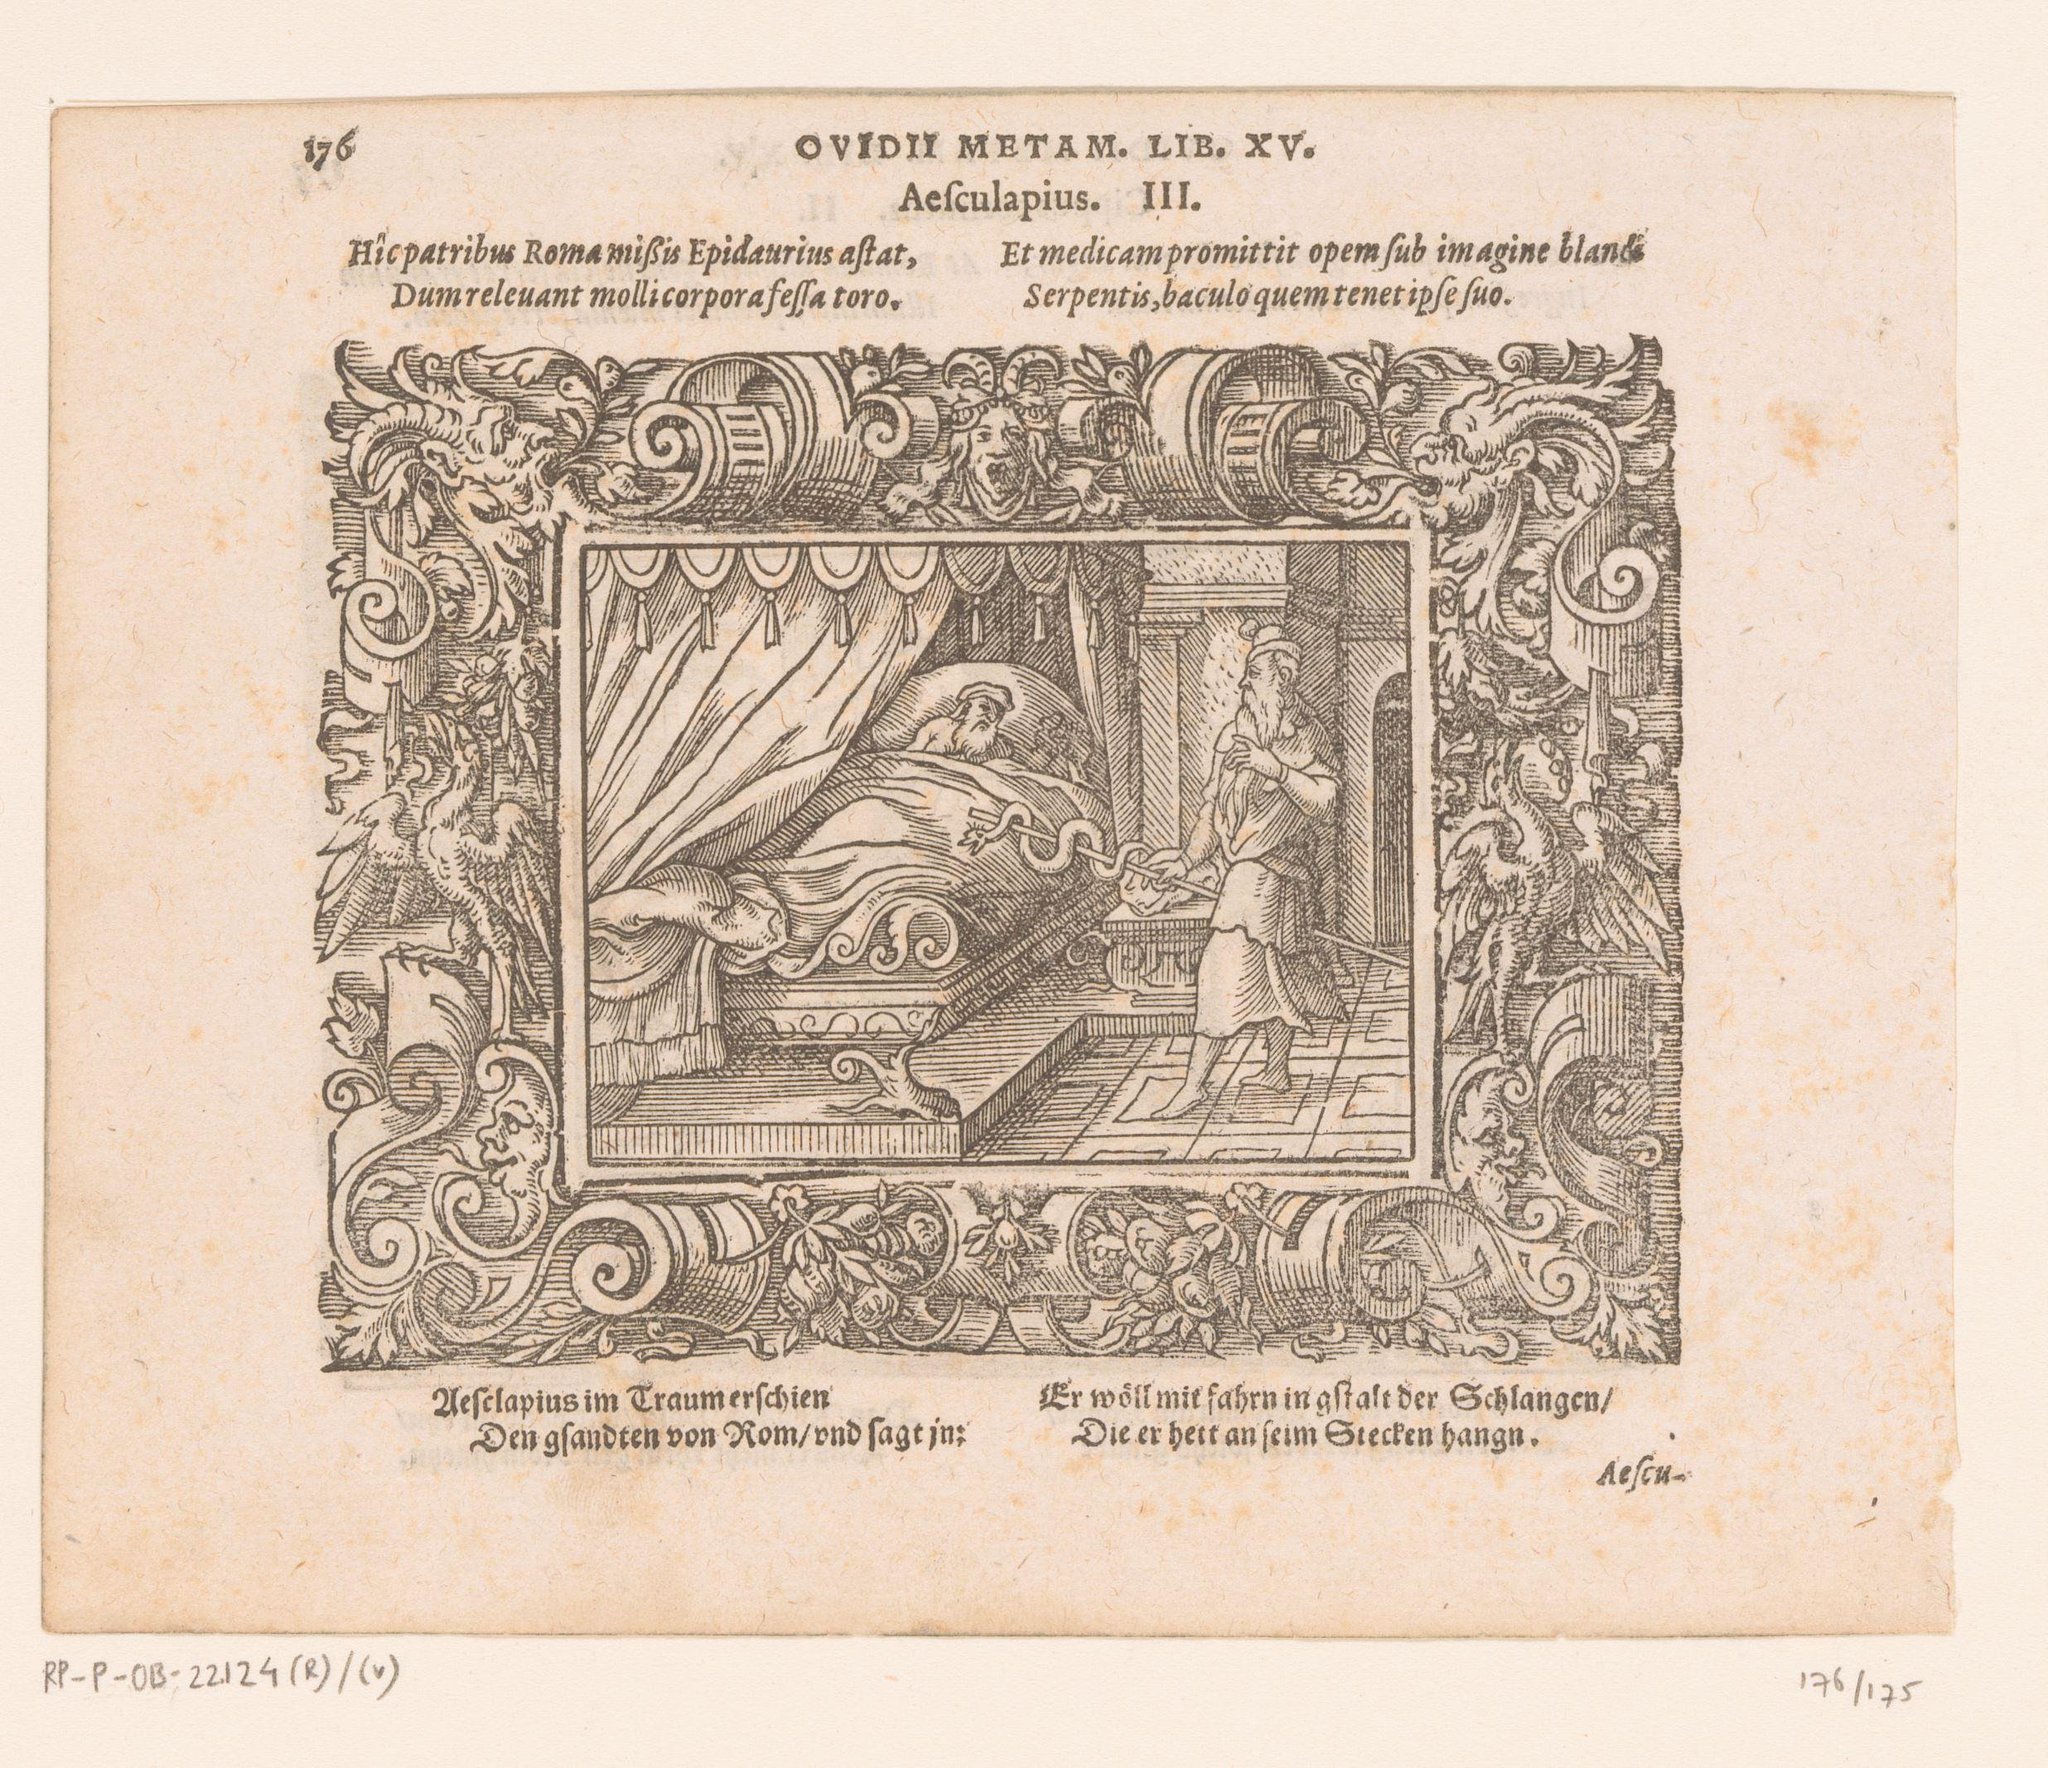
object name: print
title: Aesculapius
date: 1569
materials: paper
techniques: letterpress printing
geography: nuremberg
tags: scrollwork, strapwork ~ ornament, (story of) aesculapius (asclepius)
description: Illustratie bij de Metamorfosen van Ovidius, afkomstig uit de publicatie: Posthius, Johannes. Tetrasticha in Ovidii metam. Frankfurt am Main: Georg Rab en Sigmund Feyerabend en erven Weigand Han, 1569. De voorstellingen en ornamentranden van deze boekillustraties zijn van twee aparte blokken gedrukt. Beide werden afzonderlijk van elkaar ook gebruikt voor andere publicaties, en de ornamentranden werden eveneens binnen deze publicatie meerdere keren gebruikt.